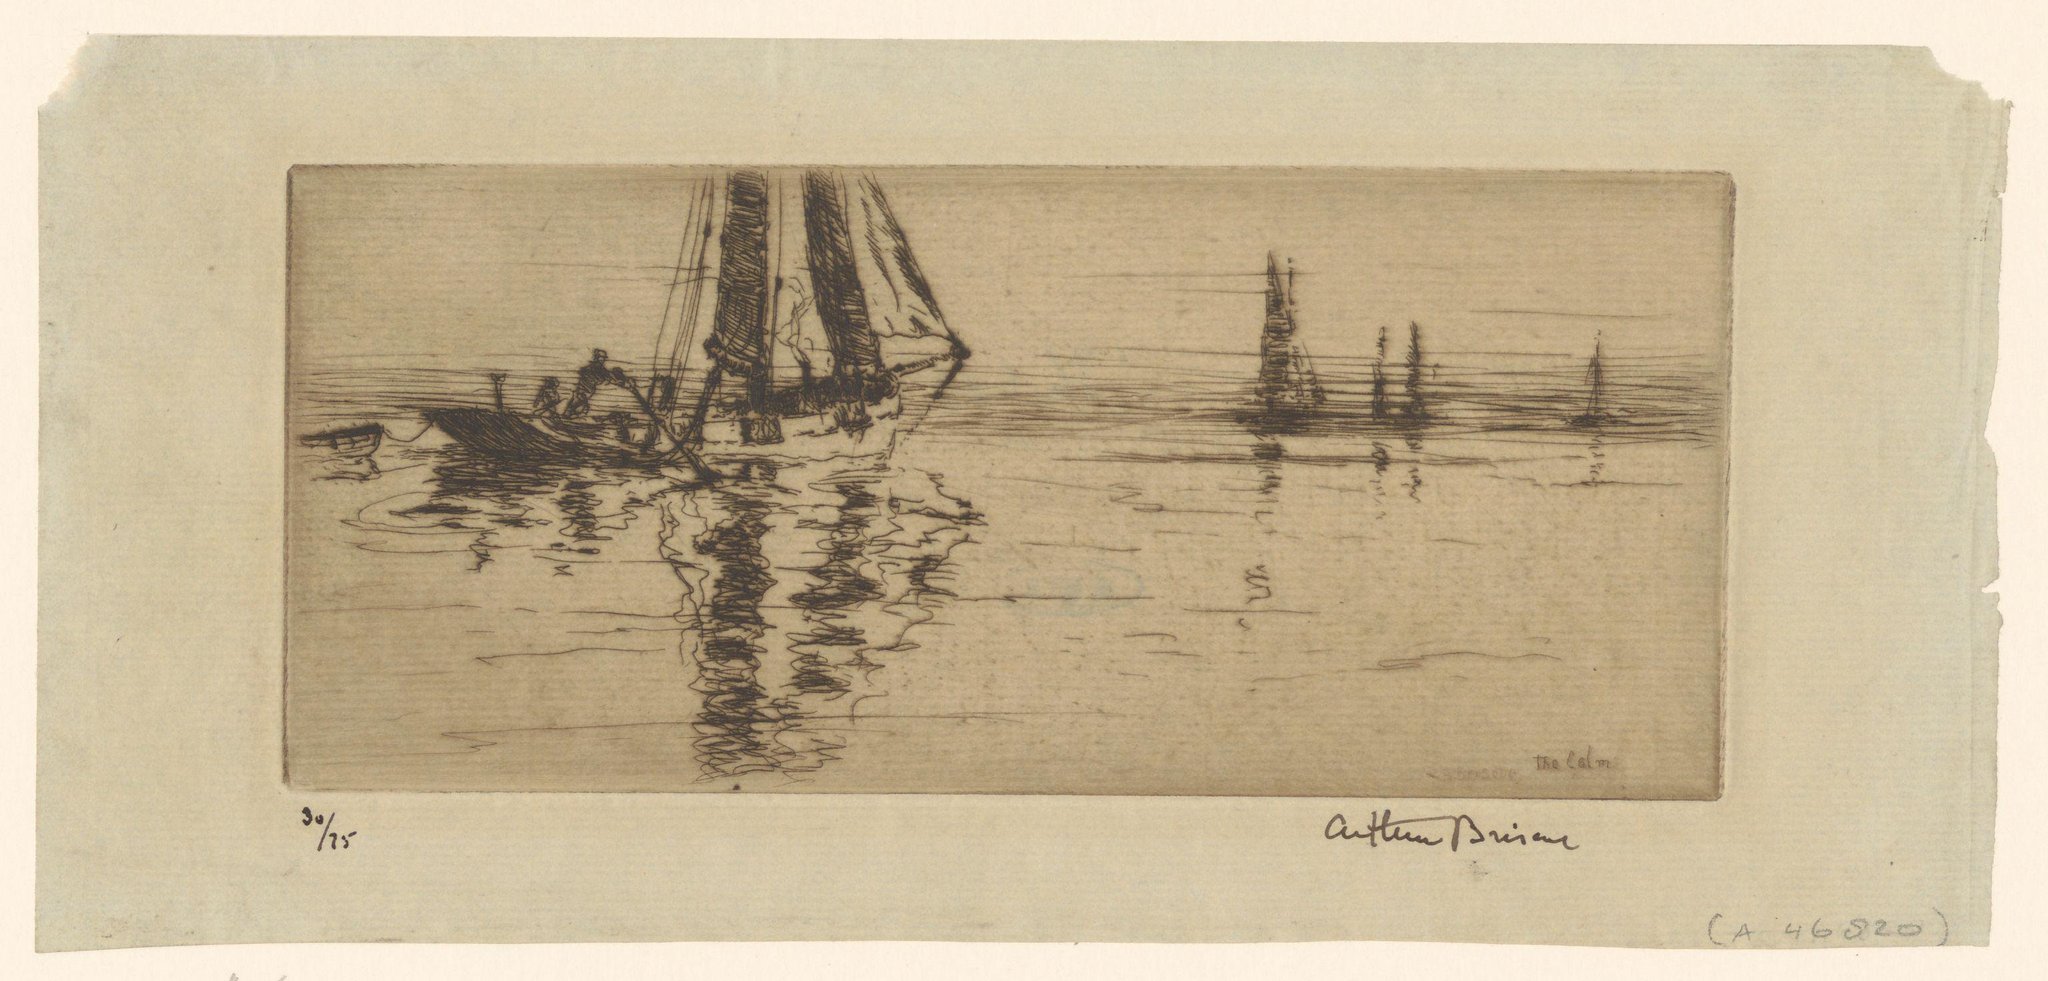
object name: print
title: The Calm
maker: arthur john trevor briscoe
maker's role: print maker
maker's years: 1873-1943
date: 1925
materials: paper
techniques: drypoint, etching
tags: sailing-ship, sailing-boat, rowing-boat, canoe, etc., mist, fog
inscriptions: collector's mark: Lugt 2228